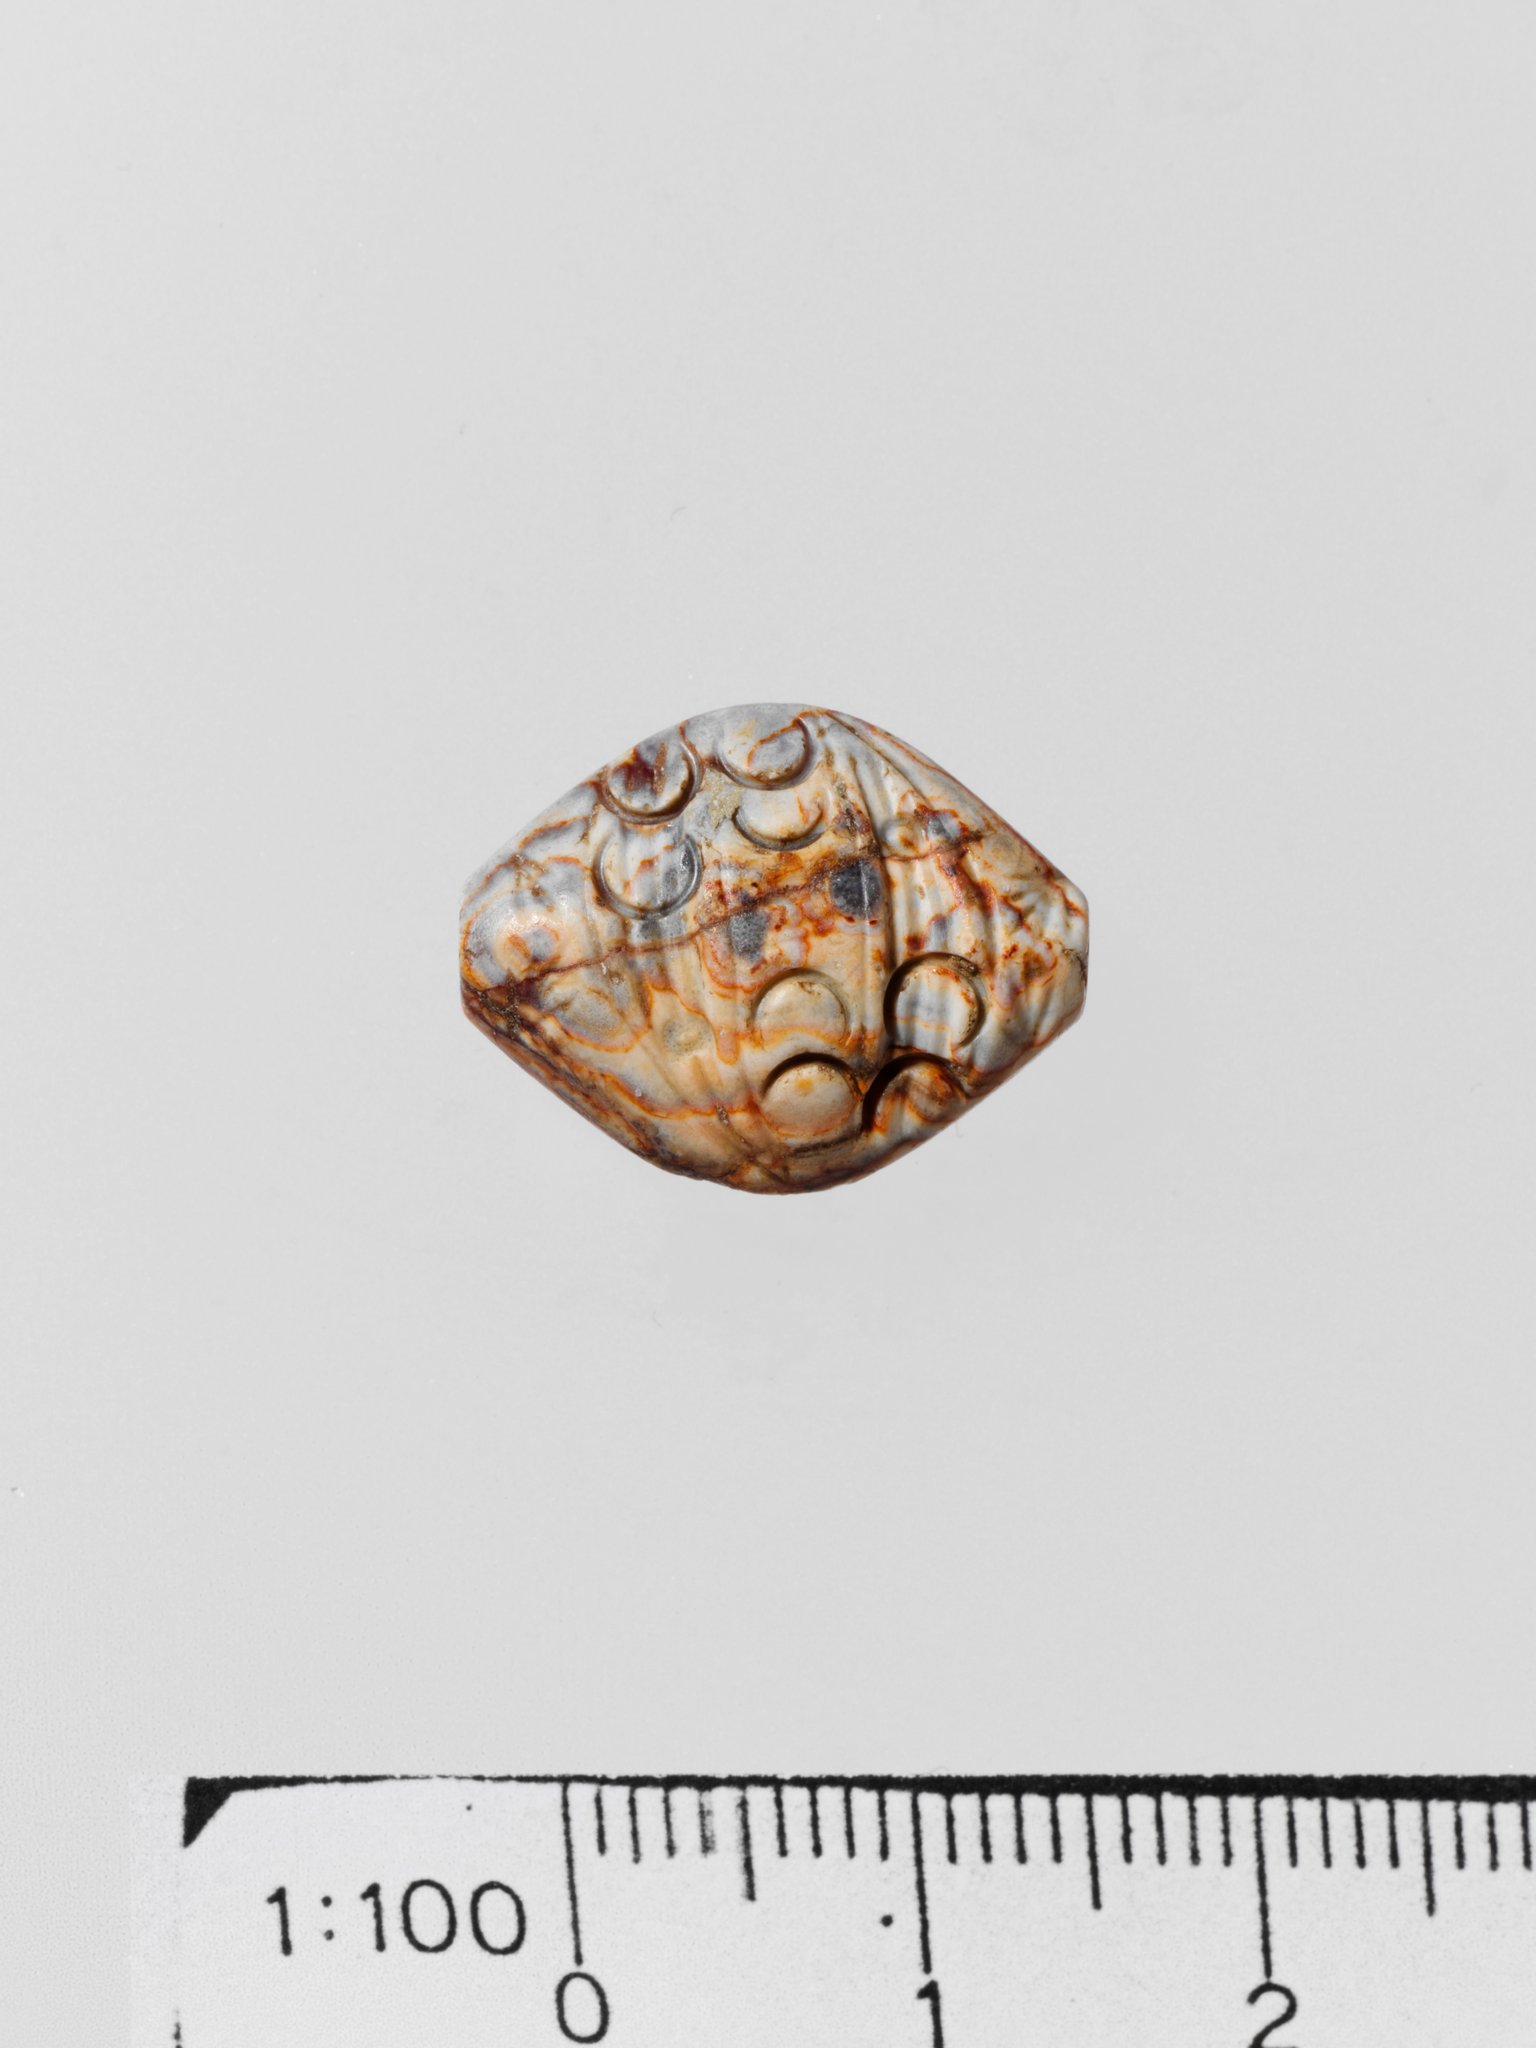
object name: seal, amygdaloid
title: Agate amygdaloid seal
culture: minoan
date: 1700-1450 BCE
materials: stone